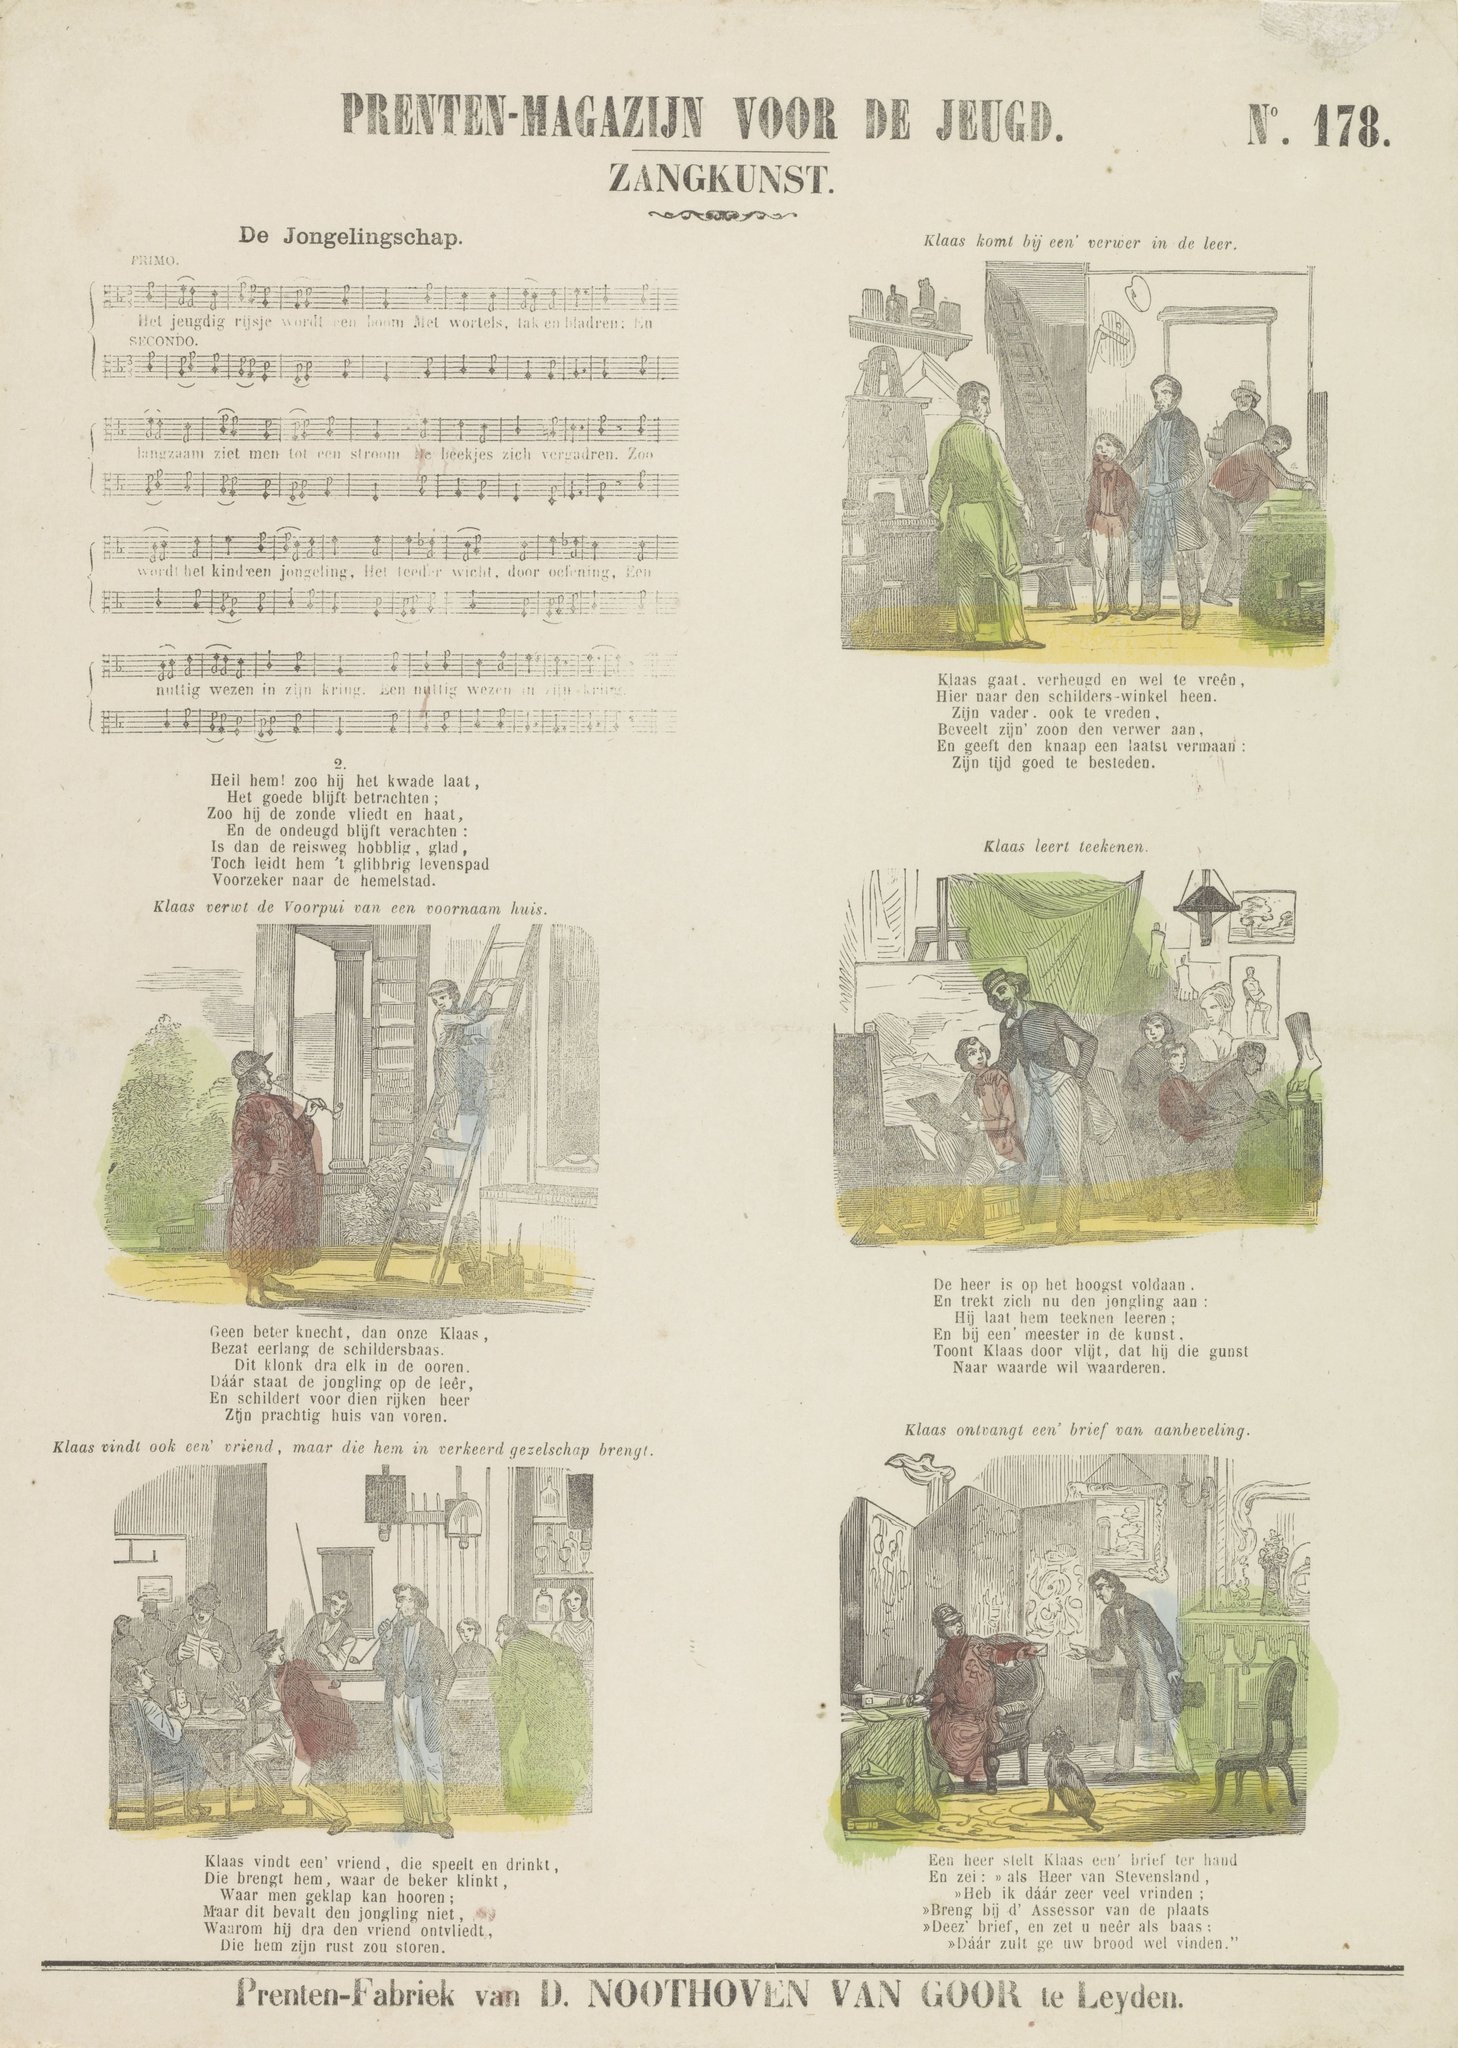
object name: popular print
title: De jongelingschap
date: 1850-1881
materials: paper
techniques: colour, letterpress printing, engraving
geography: leiden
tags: painter at work, in his studio, drawing-lesson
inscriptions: collector's mark: Lugt 2760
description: Blad met 5 voorstellingen en een stuk bladmuziek met een lied over het leven van Klaas, die leert schilderen en tekenen. Boven elke voorstelling een titel en onder elke voorstelling coupletten van het lied. Genummerd rechtsboven: No. 178.